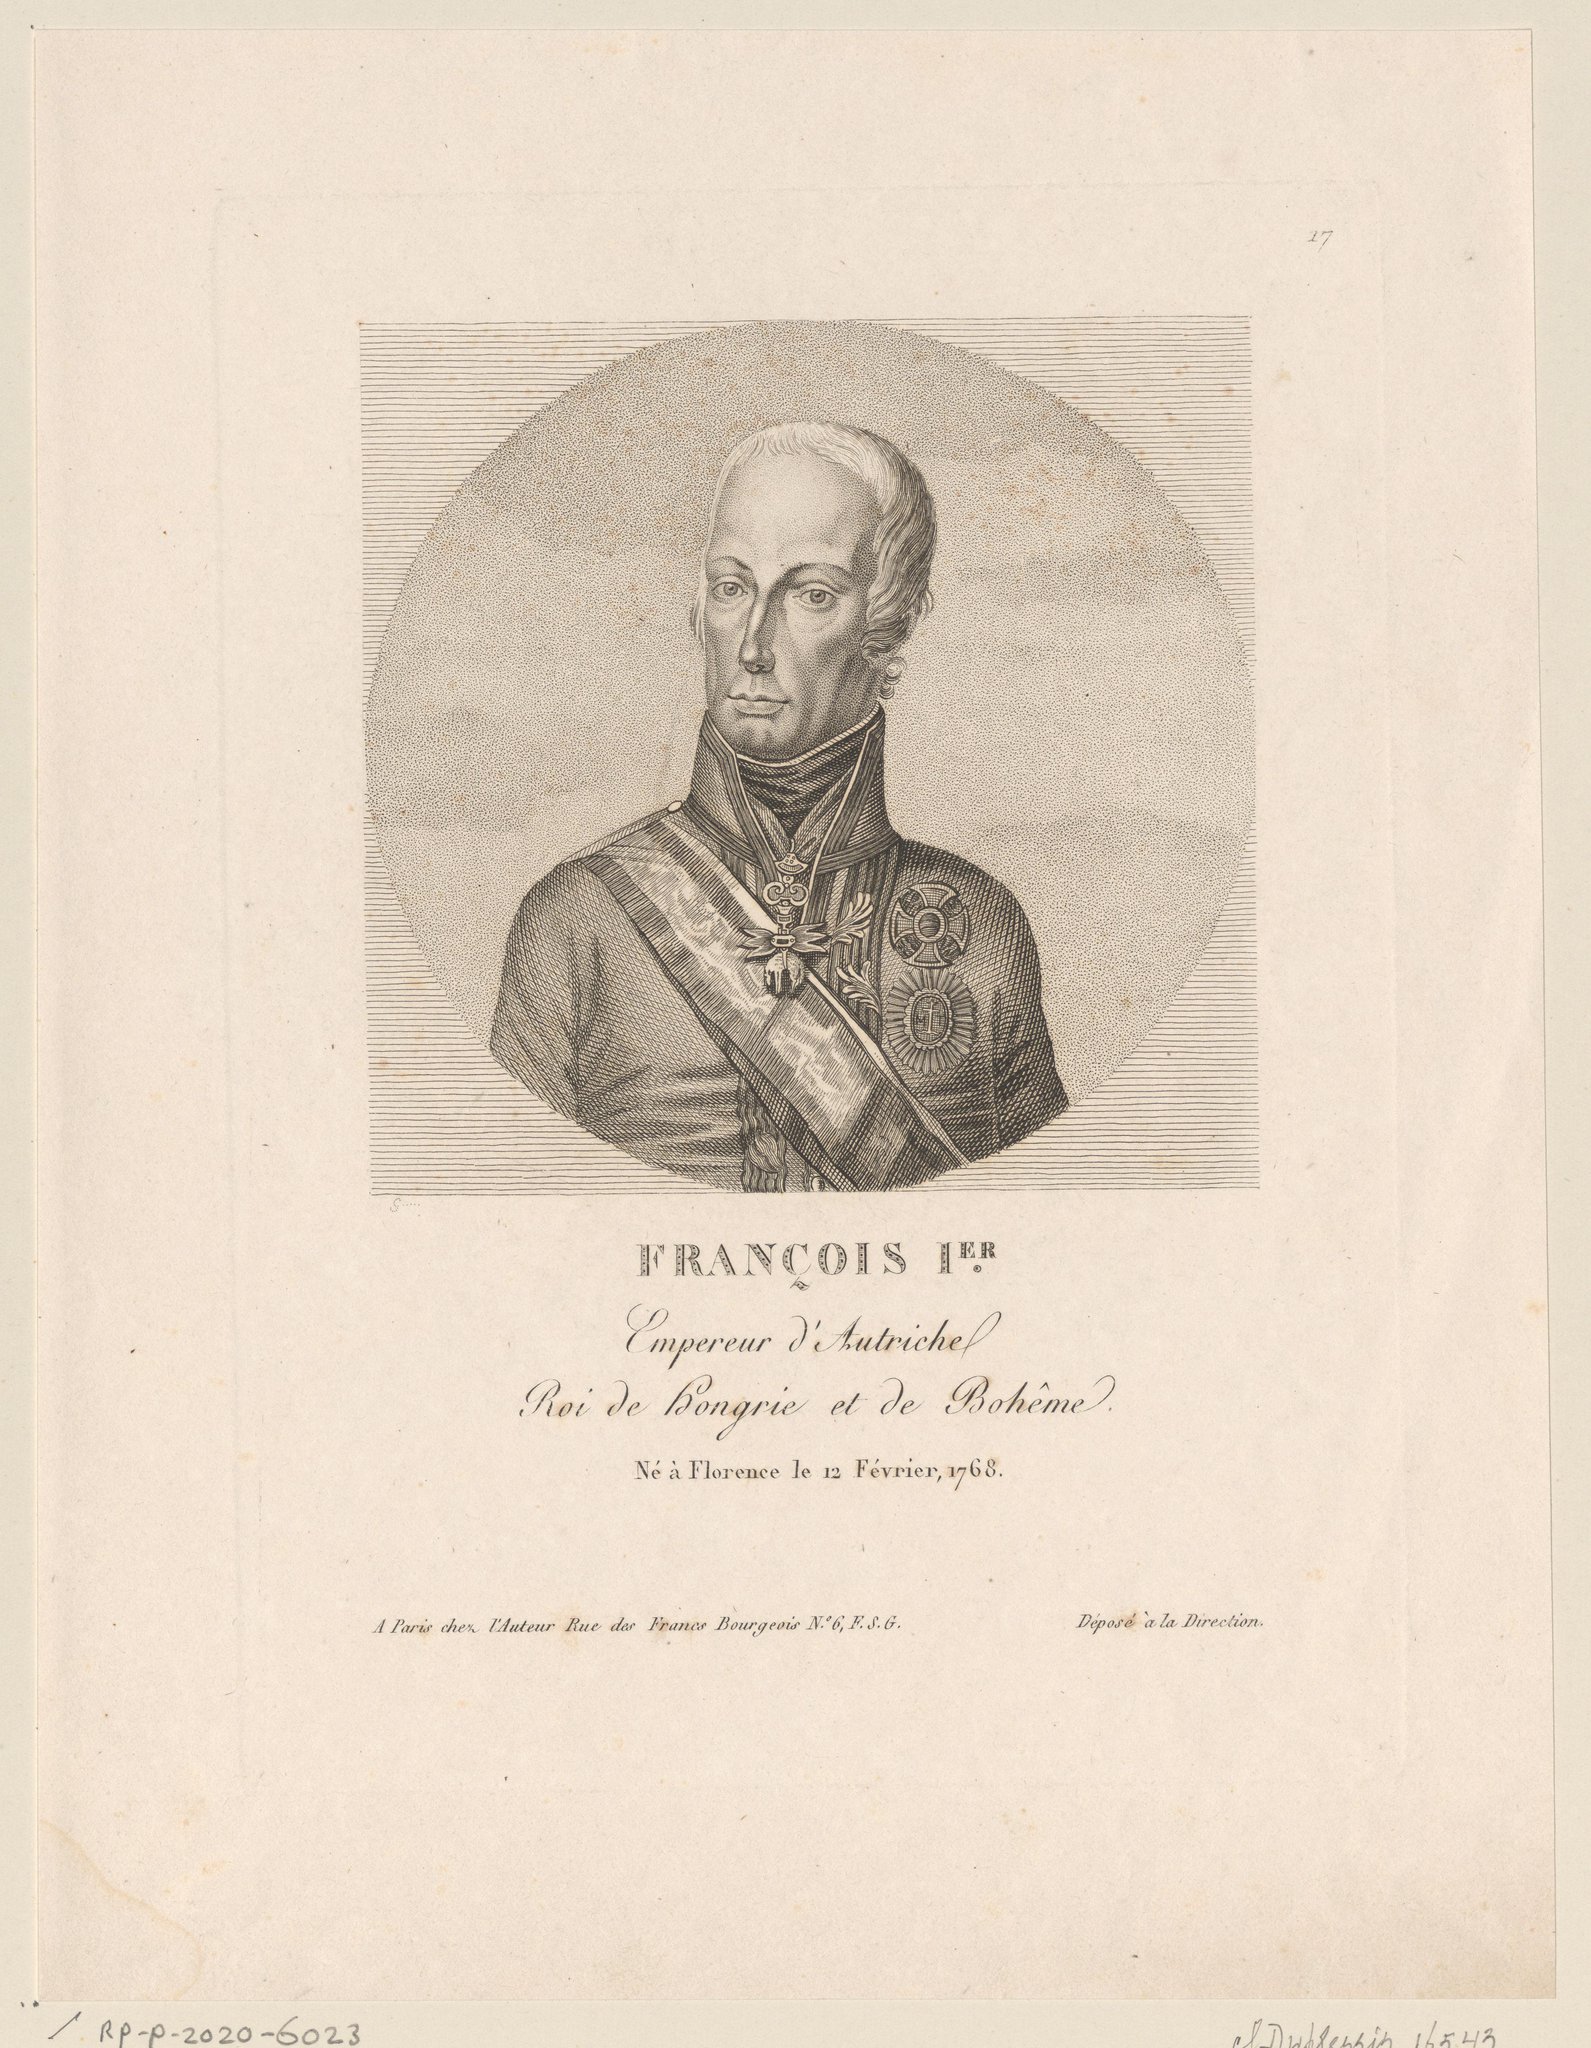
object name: print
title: Portret van Frans I, keizer van Oostenrijk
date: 1804-1835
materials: paper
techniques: etching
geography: paris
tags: vienna, frans ii (rooms-duits keizer), historical persons, knighthood order of the golden fleece, emperor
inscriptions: : ‘Déposé à la Direction’